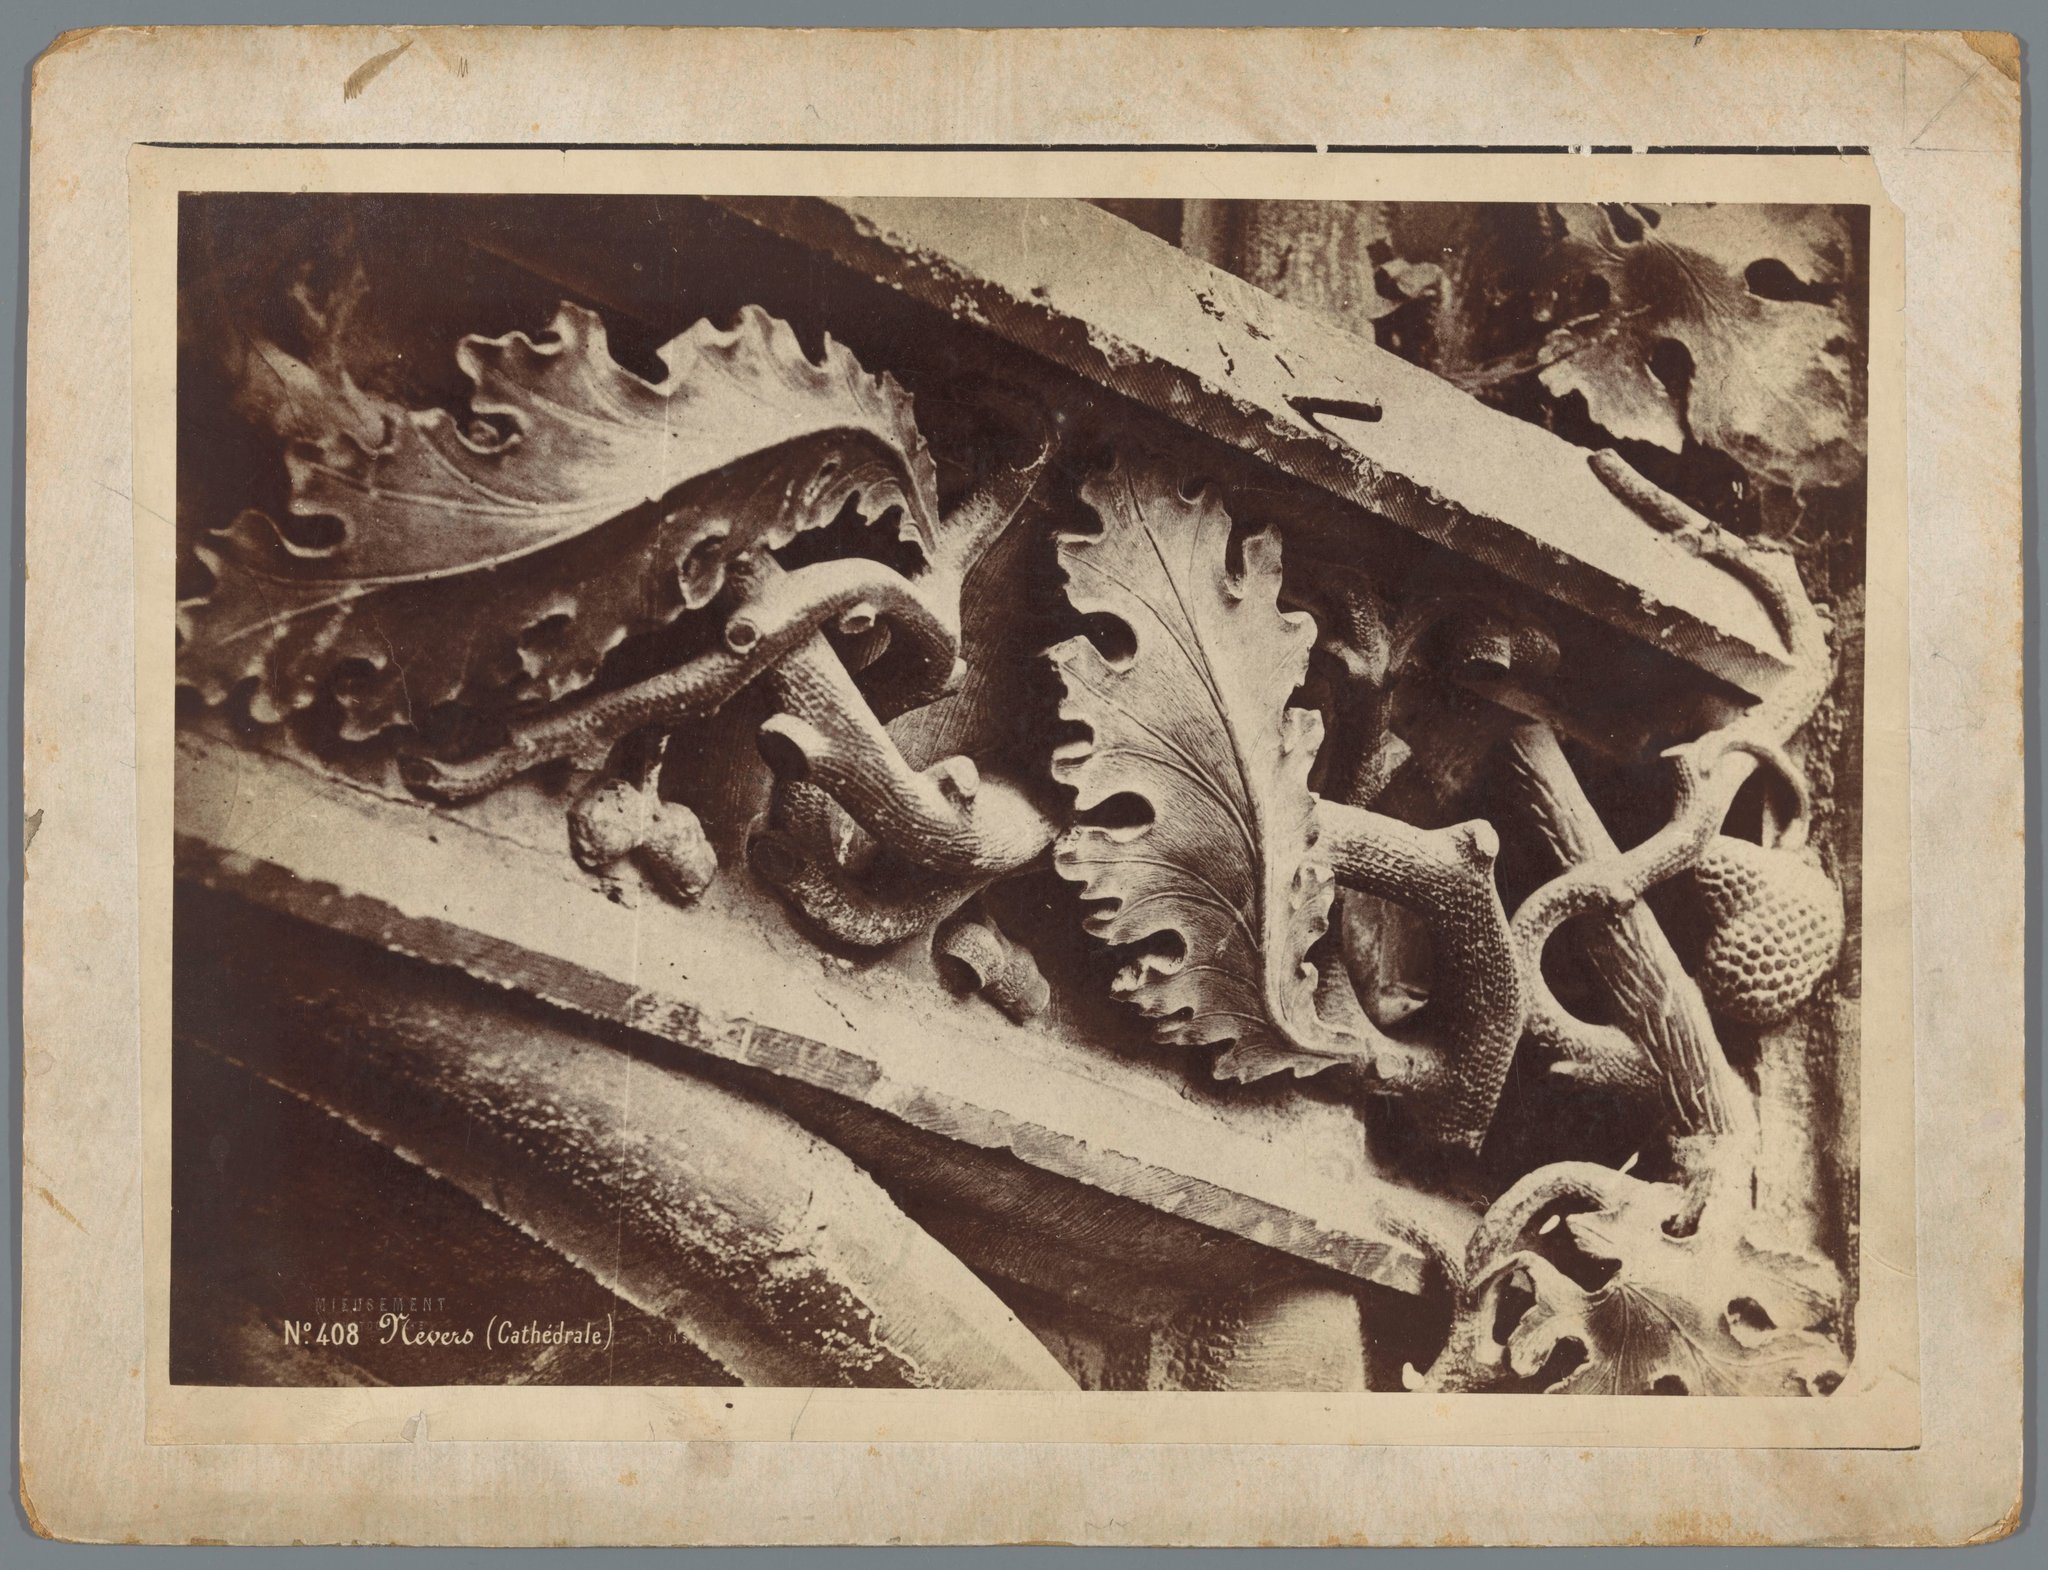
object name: photograph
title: Nevers (Cathédrale)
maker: séraphin-médéric mieusement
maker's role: fotograaf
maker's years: 1840-1905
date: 1875-1900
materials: cardboard, photographic support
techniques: albumen print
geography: nevers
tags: foliage, tendrils, branches ~ ornament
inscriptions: name: ‘MIEUSEMENT PHOTOGRAPHE’, collector's mark: Lugt 3937, inscription: ‘MONUMENTS HISTORIQUES’, inscription: ‘B&K sculpt’, number: ‘No. 408’